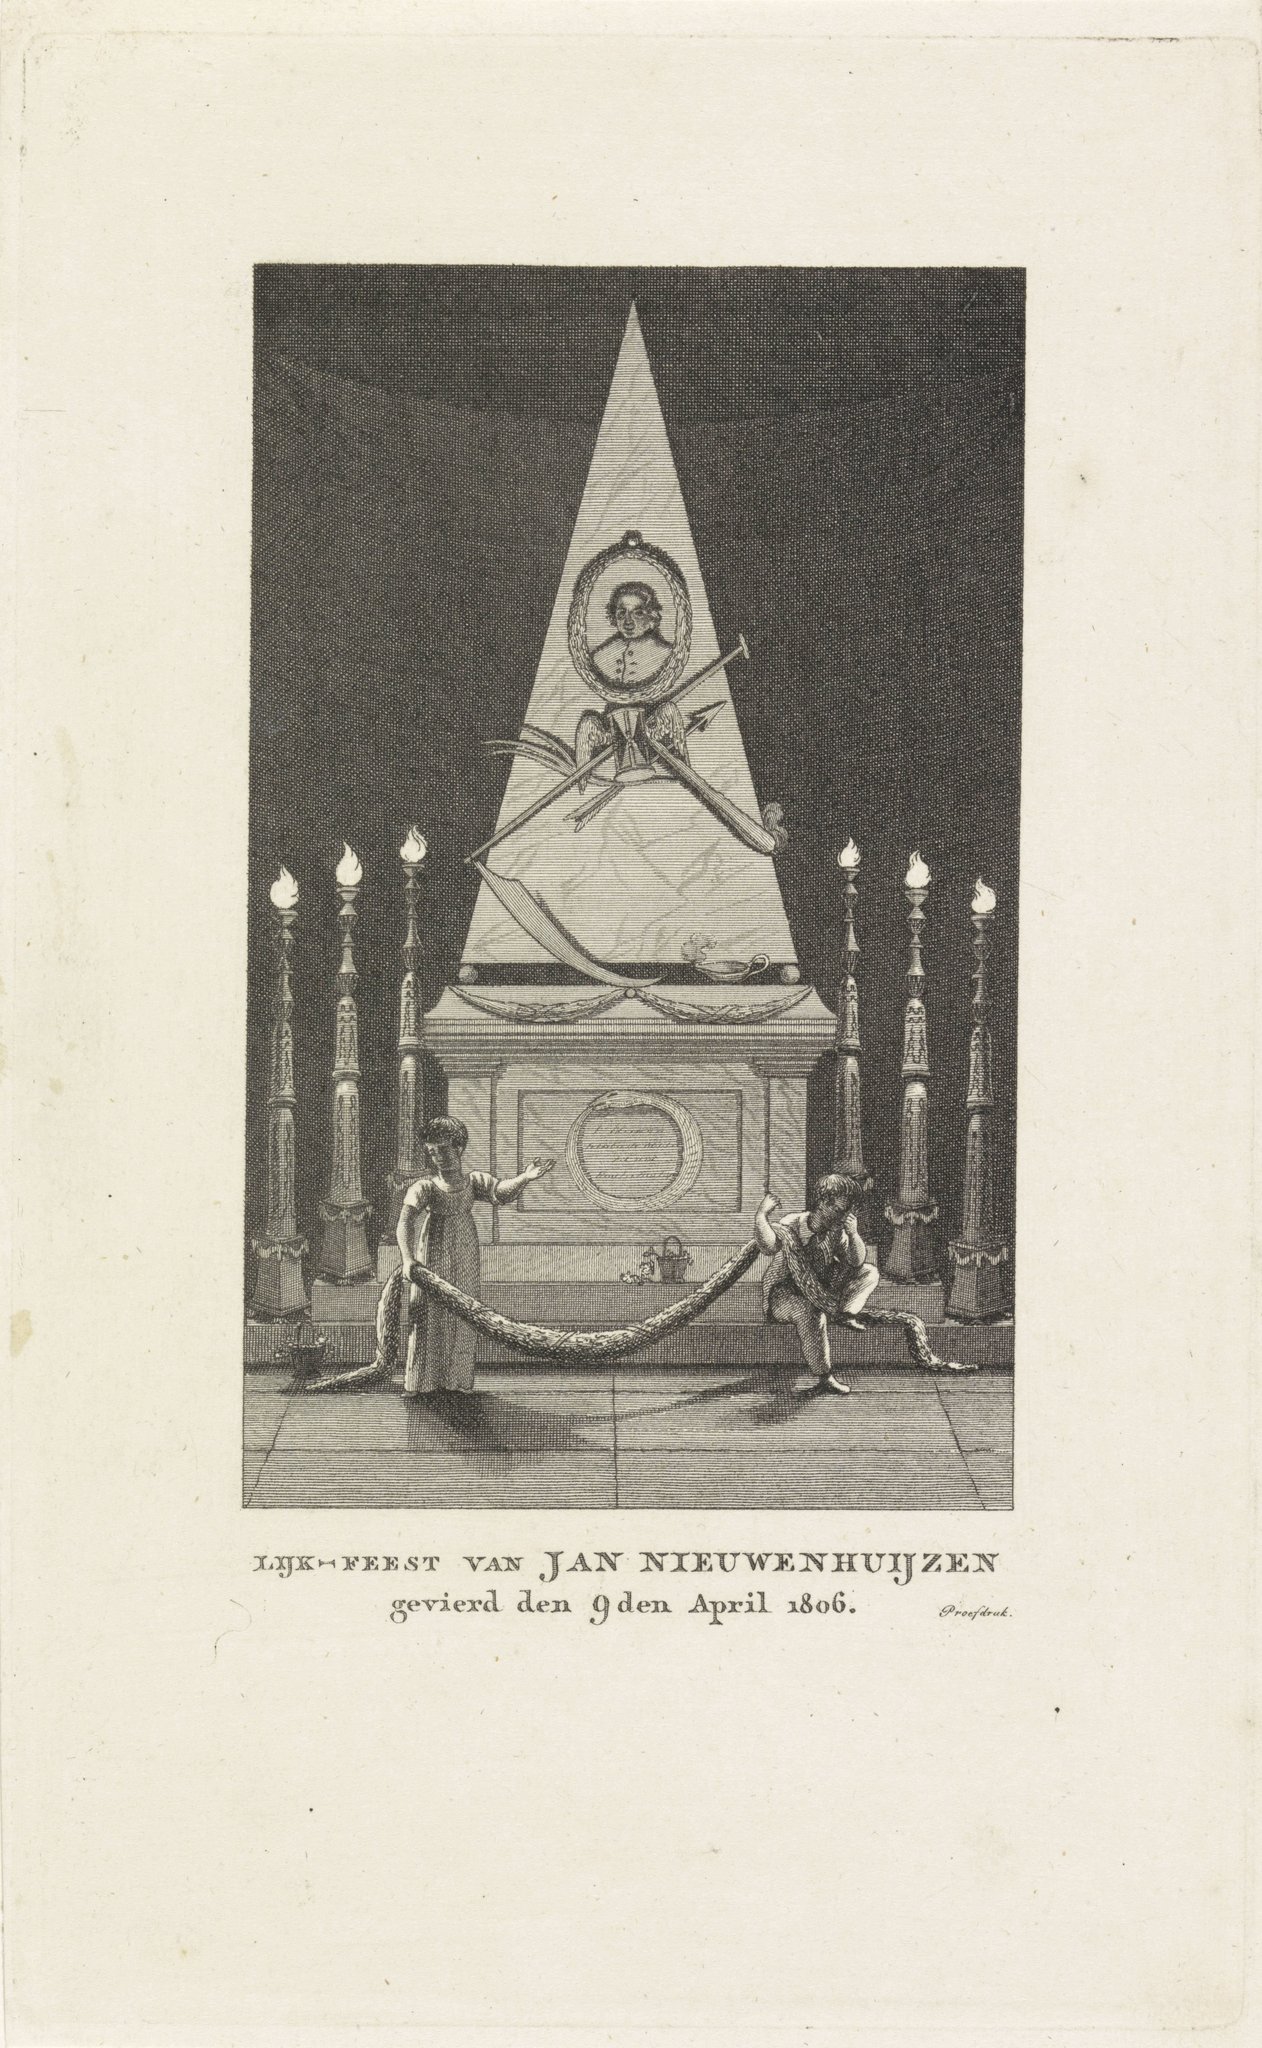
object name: print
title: Lijk-feest van Jan Nieuwenhuijzen gevierd den 9den April 1806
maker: Anonymous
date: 1807-1808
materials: paper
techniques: etching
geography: netherlands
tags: haarlem, amsterdam, jan nieuwenhuyzen, grave-building, monumental tomb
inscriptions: collector's mark: Lugt 2228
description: Allegorisch grafmonument voor de op 24 februari 1806 overleden Jan Nieuwenhuyzen, oprichter van de Maatschappij tot Nut van 't Algemeen. Tombe met piramide met zes brandende olielampen. Voor het monument twee kinderen met een guirlande.